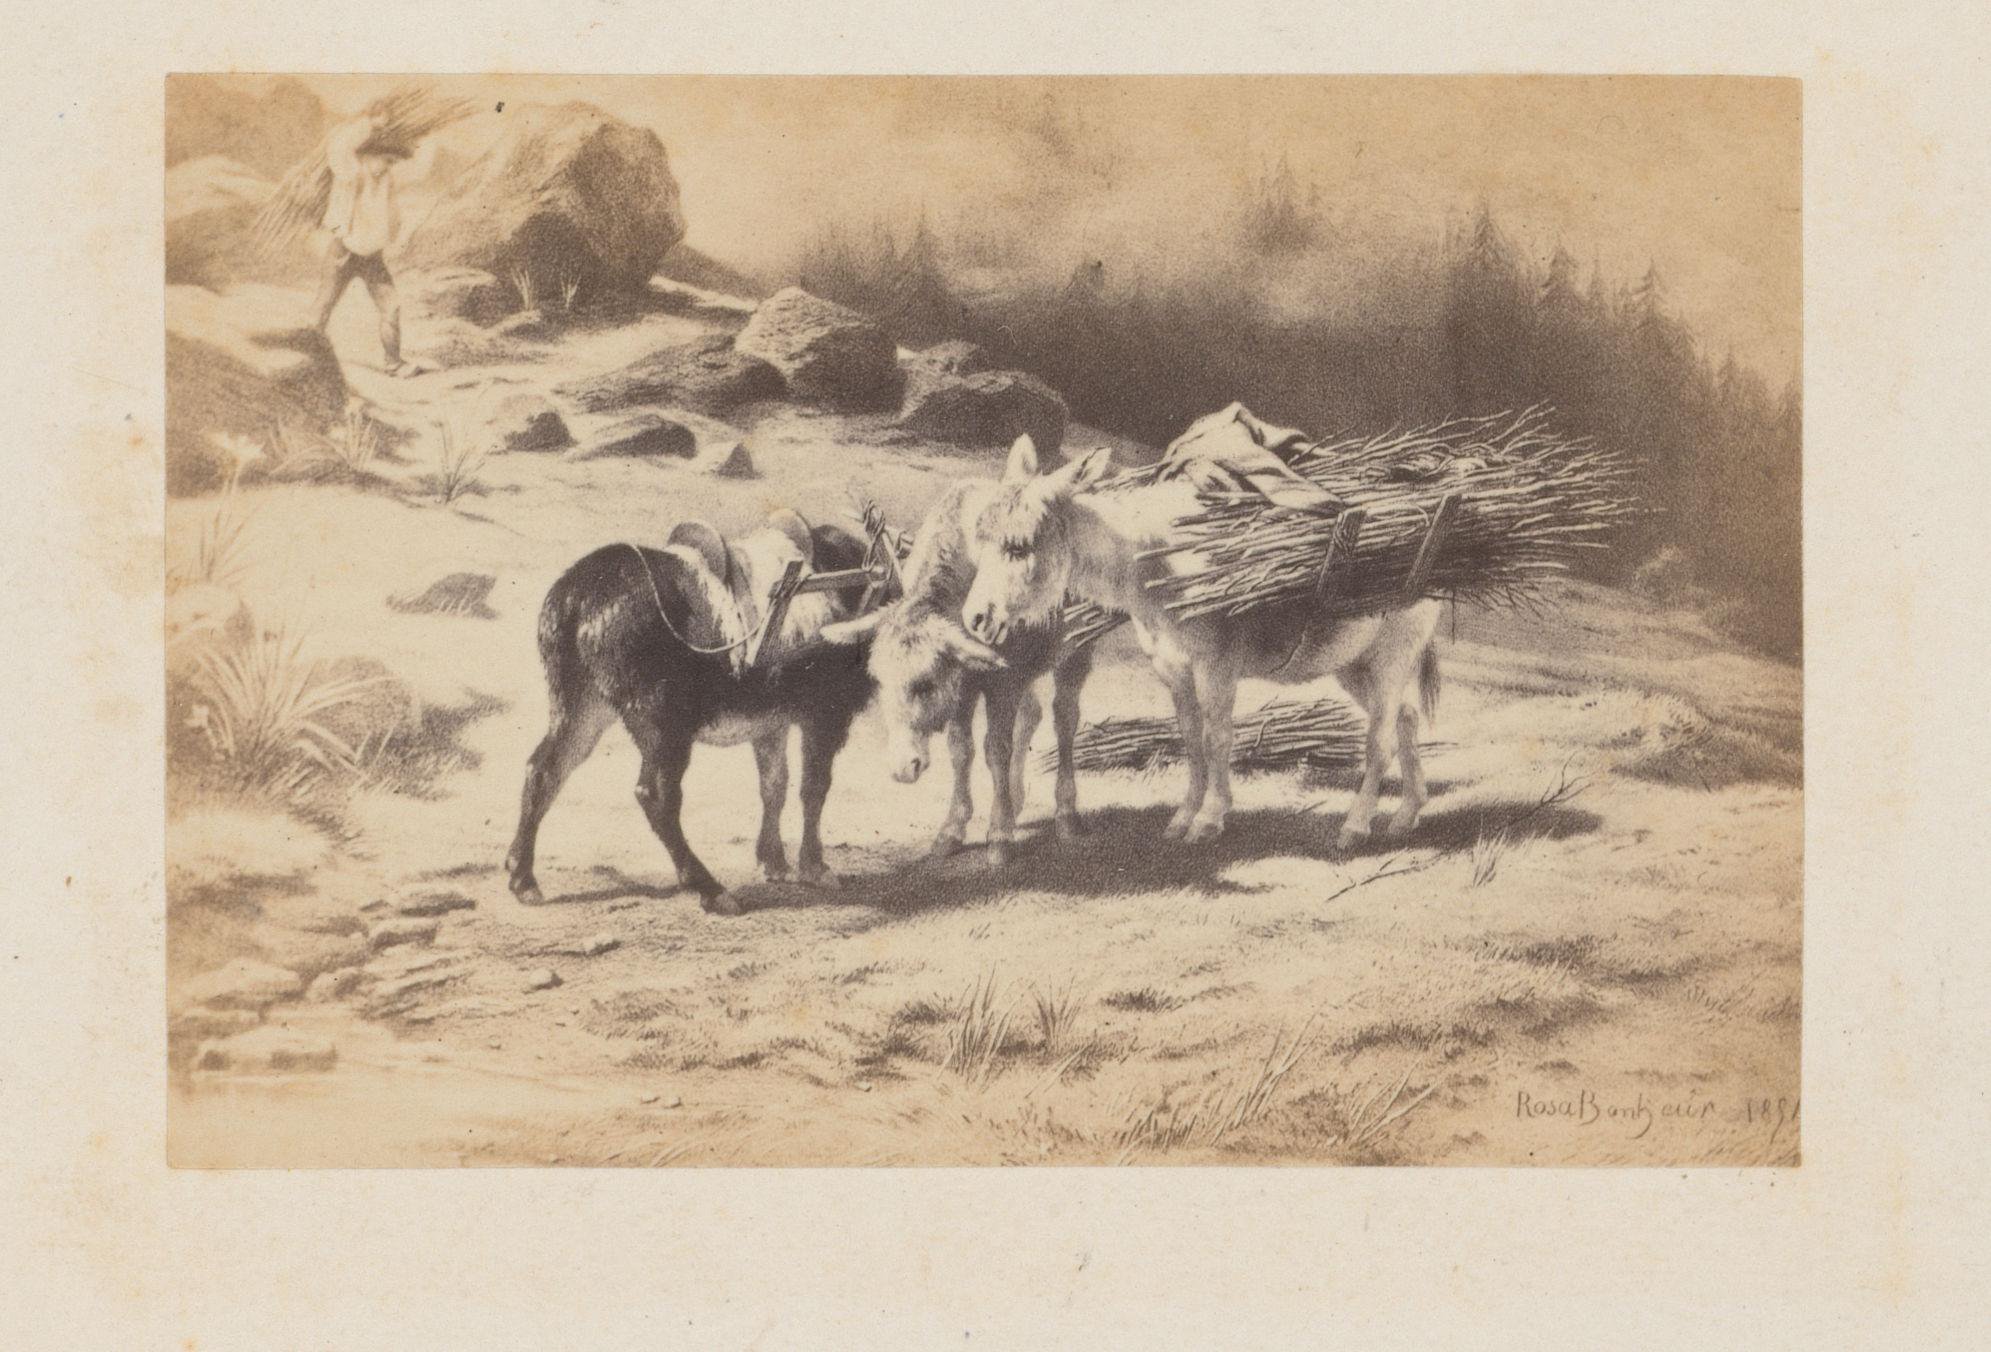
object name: page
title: Fotoreproductie van een schilderij van Rosa Bonheur van pakezels in een berglandschap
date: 1890-1910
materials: paper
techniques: albumen print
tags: ass, donkey